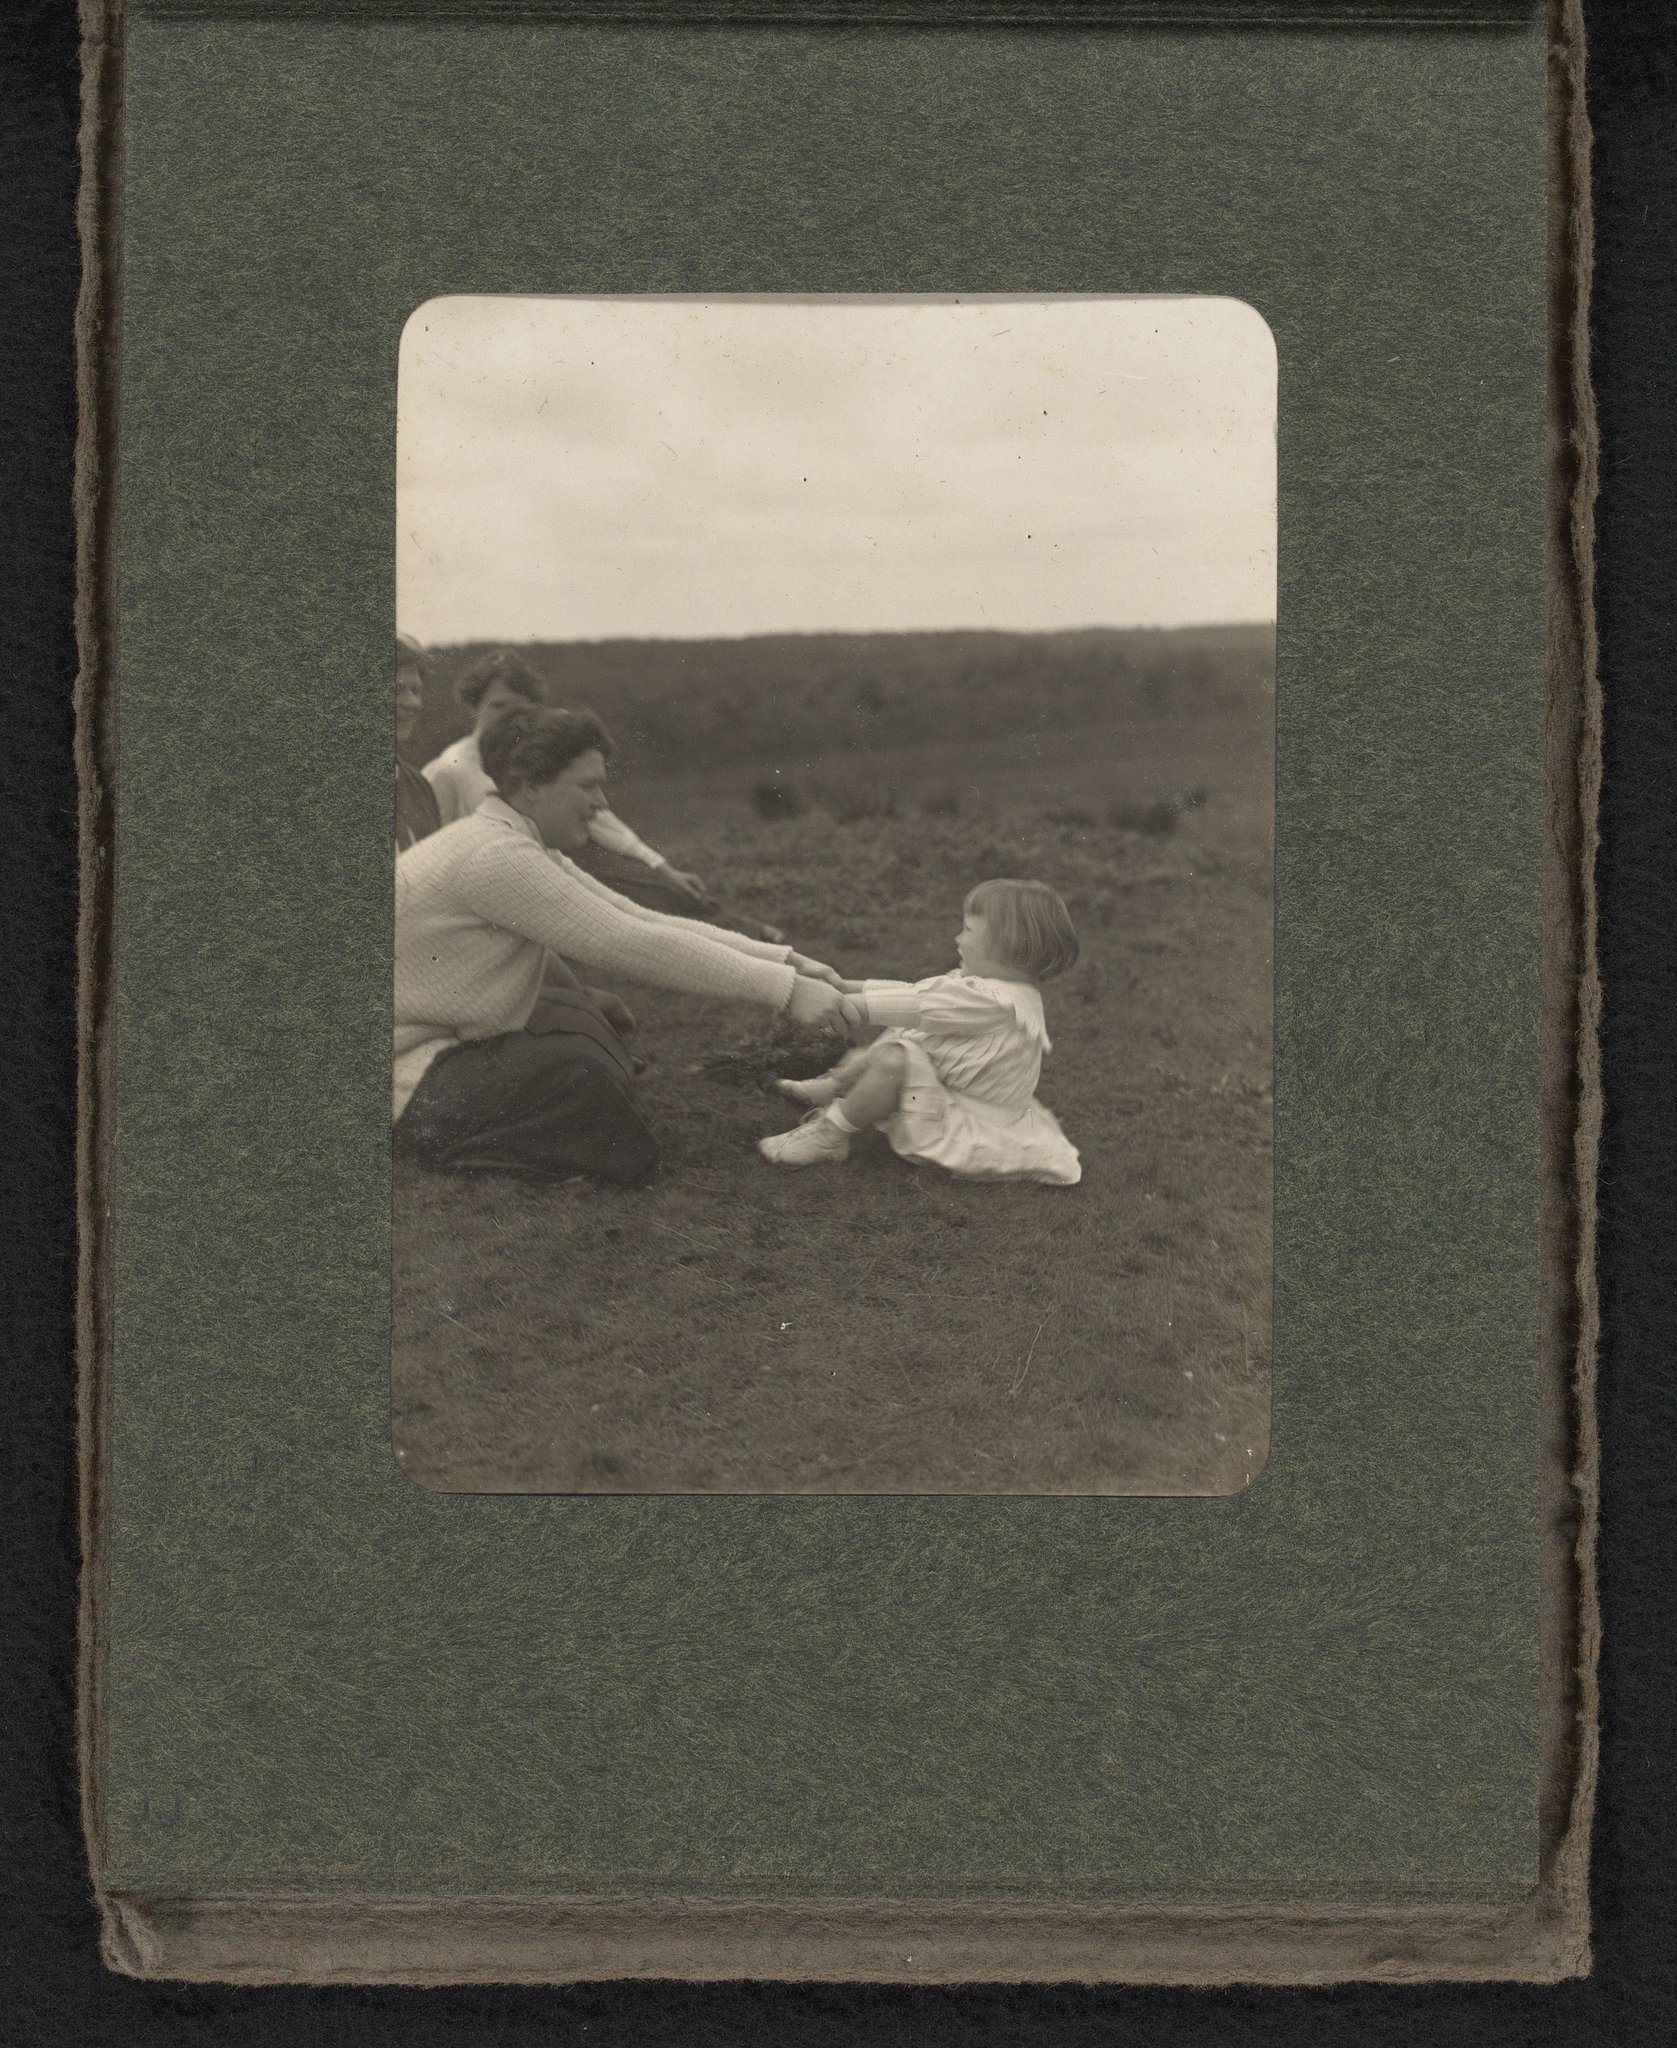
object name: album leaf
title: Drie vrouwen en Cay van den Berg in een veld te Laren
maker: hendrik herman van den berg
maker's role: amateurfotograaf, jurist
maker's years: 1875-1944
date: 1912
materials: paper, cardboard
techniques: gelatin silver print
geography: laren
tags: amsterdam, carel frederik van den berg (cay), toddler, historical persons, meadow, pasture